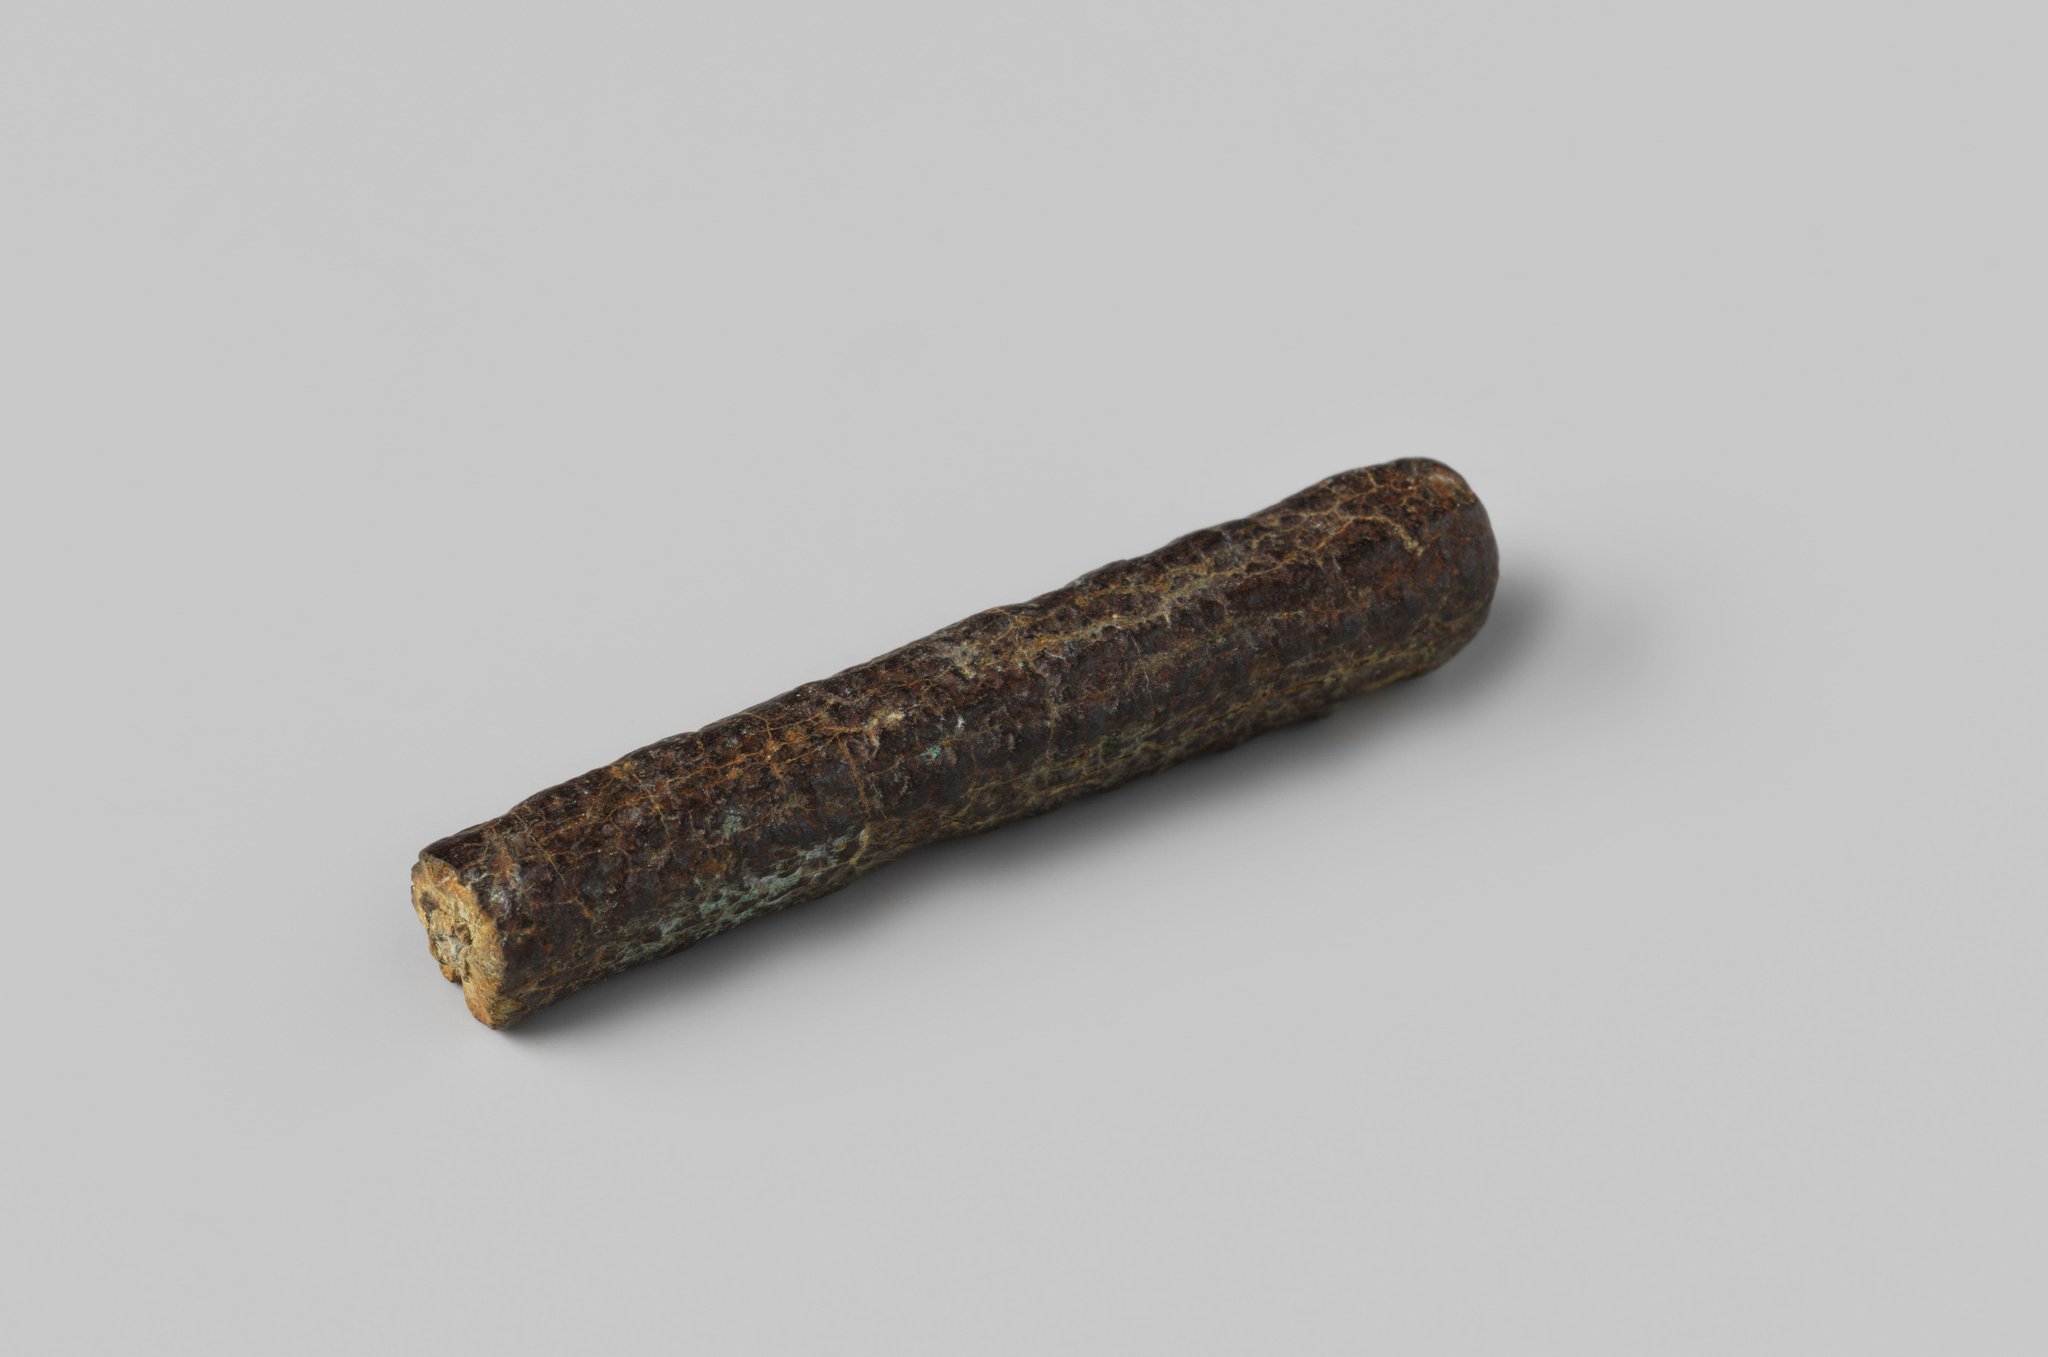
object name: helve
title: Steel van vork of lepel uit het wrak van de Oost-Indiëvaarder Hollandia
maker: Anonymous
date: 1700-1743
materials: copper, wood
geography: netherlands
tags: verenigde oostindische compagnie, hollandia (schip), annet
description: Cutlery, fragment: stem of fork or spoon; fragm, flat, widening.